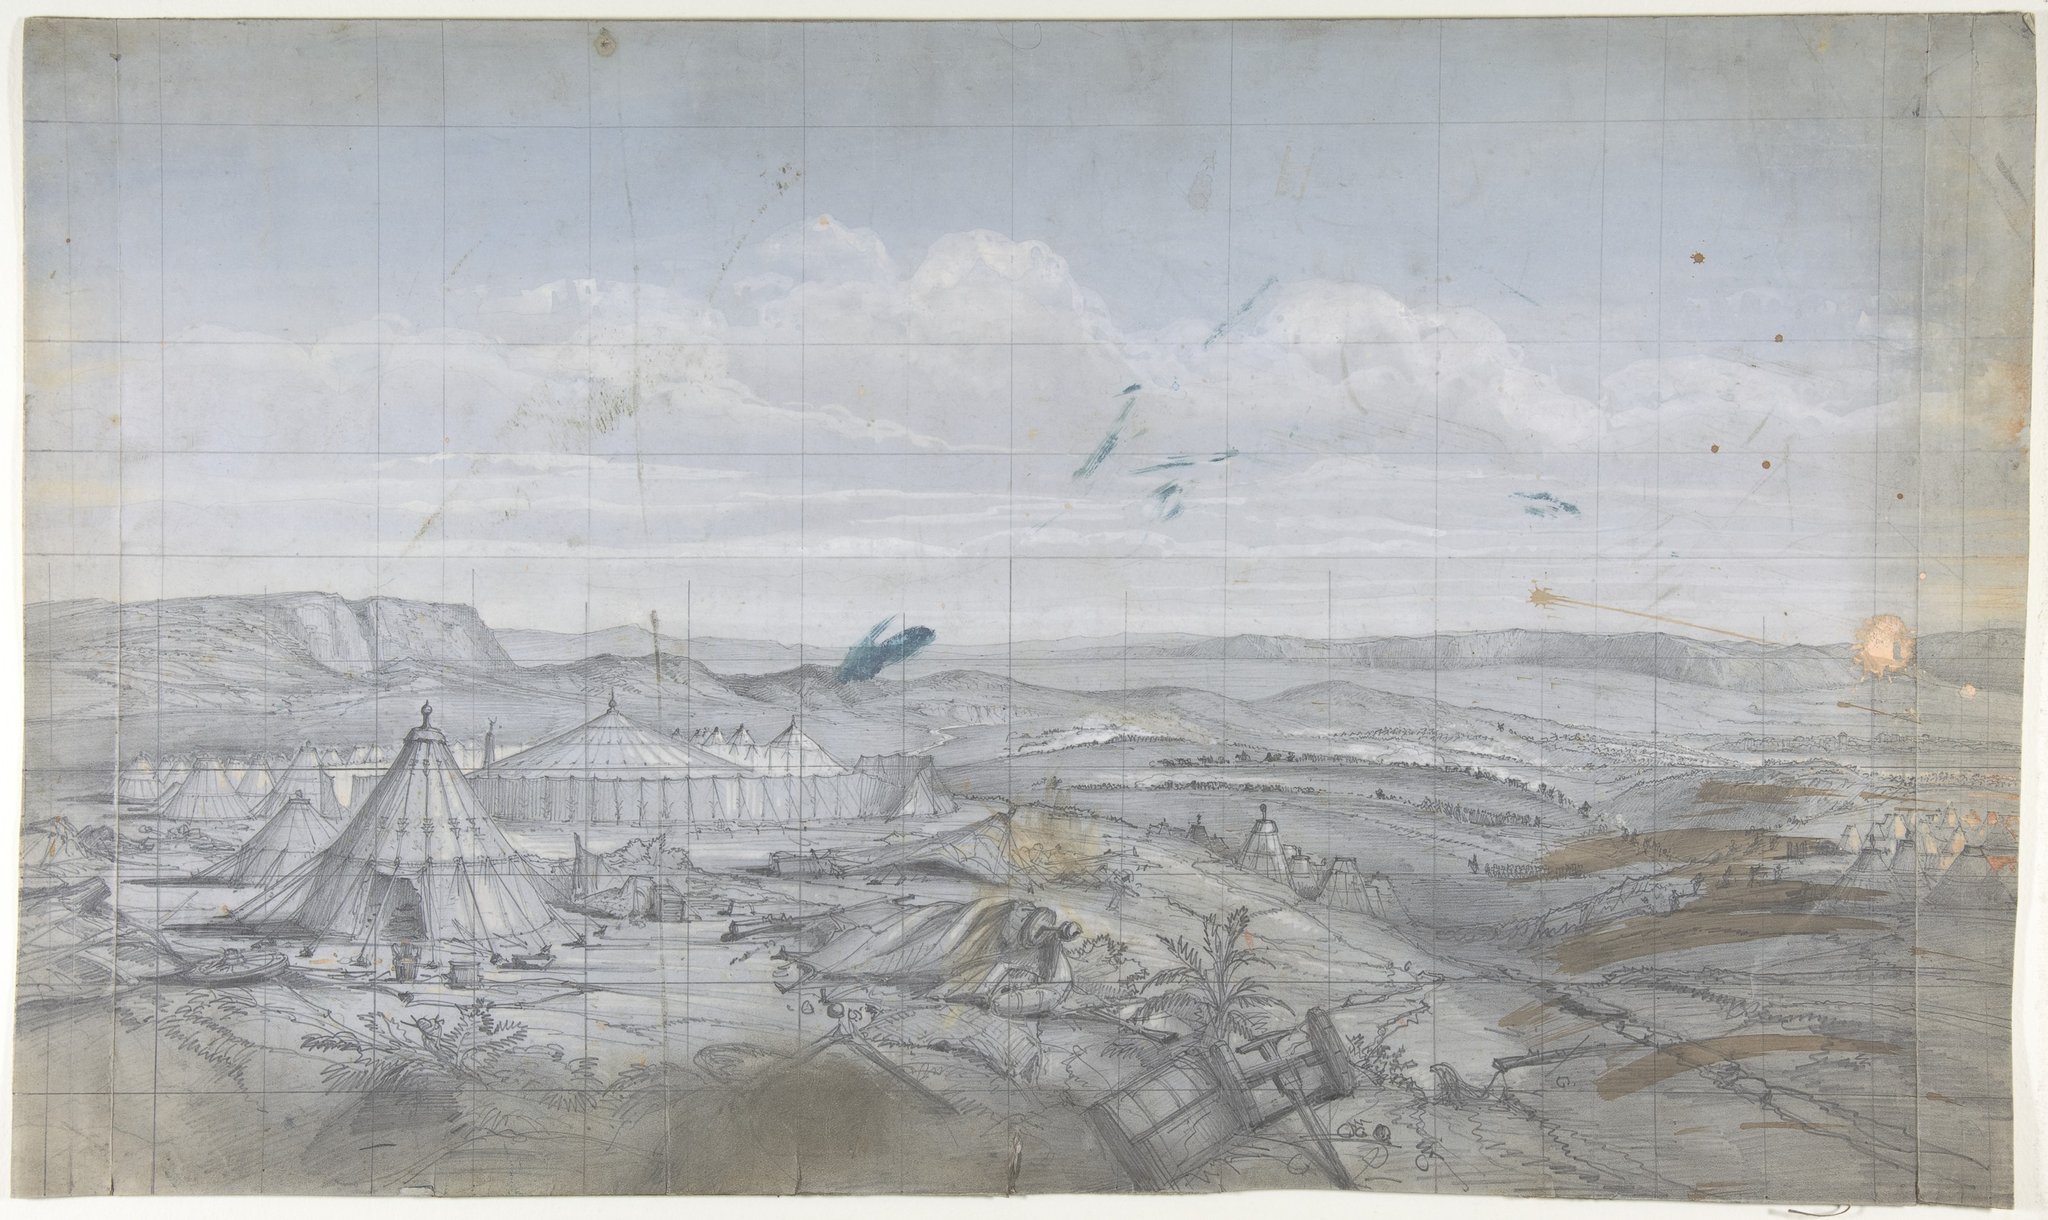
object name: drawing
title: Design for a Stage Set at the Opéra, Paris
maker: eugène cicéri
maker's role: artist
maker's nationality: french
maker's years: 1813-1890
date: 1830-1890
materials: gouache, graphite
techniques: brush, heightening, wash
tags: tents,landscapes,stage design